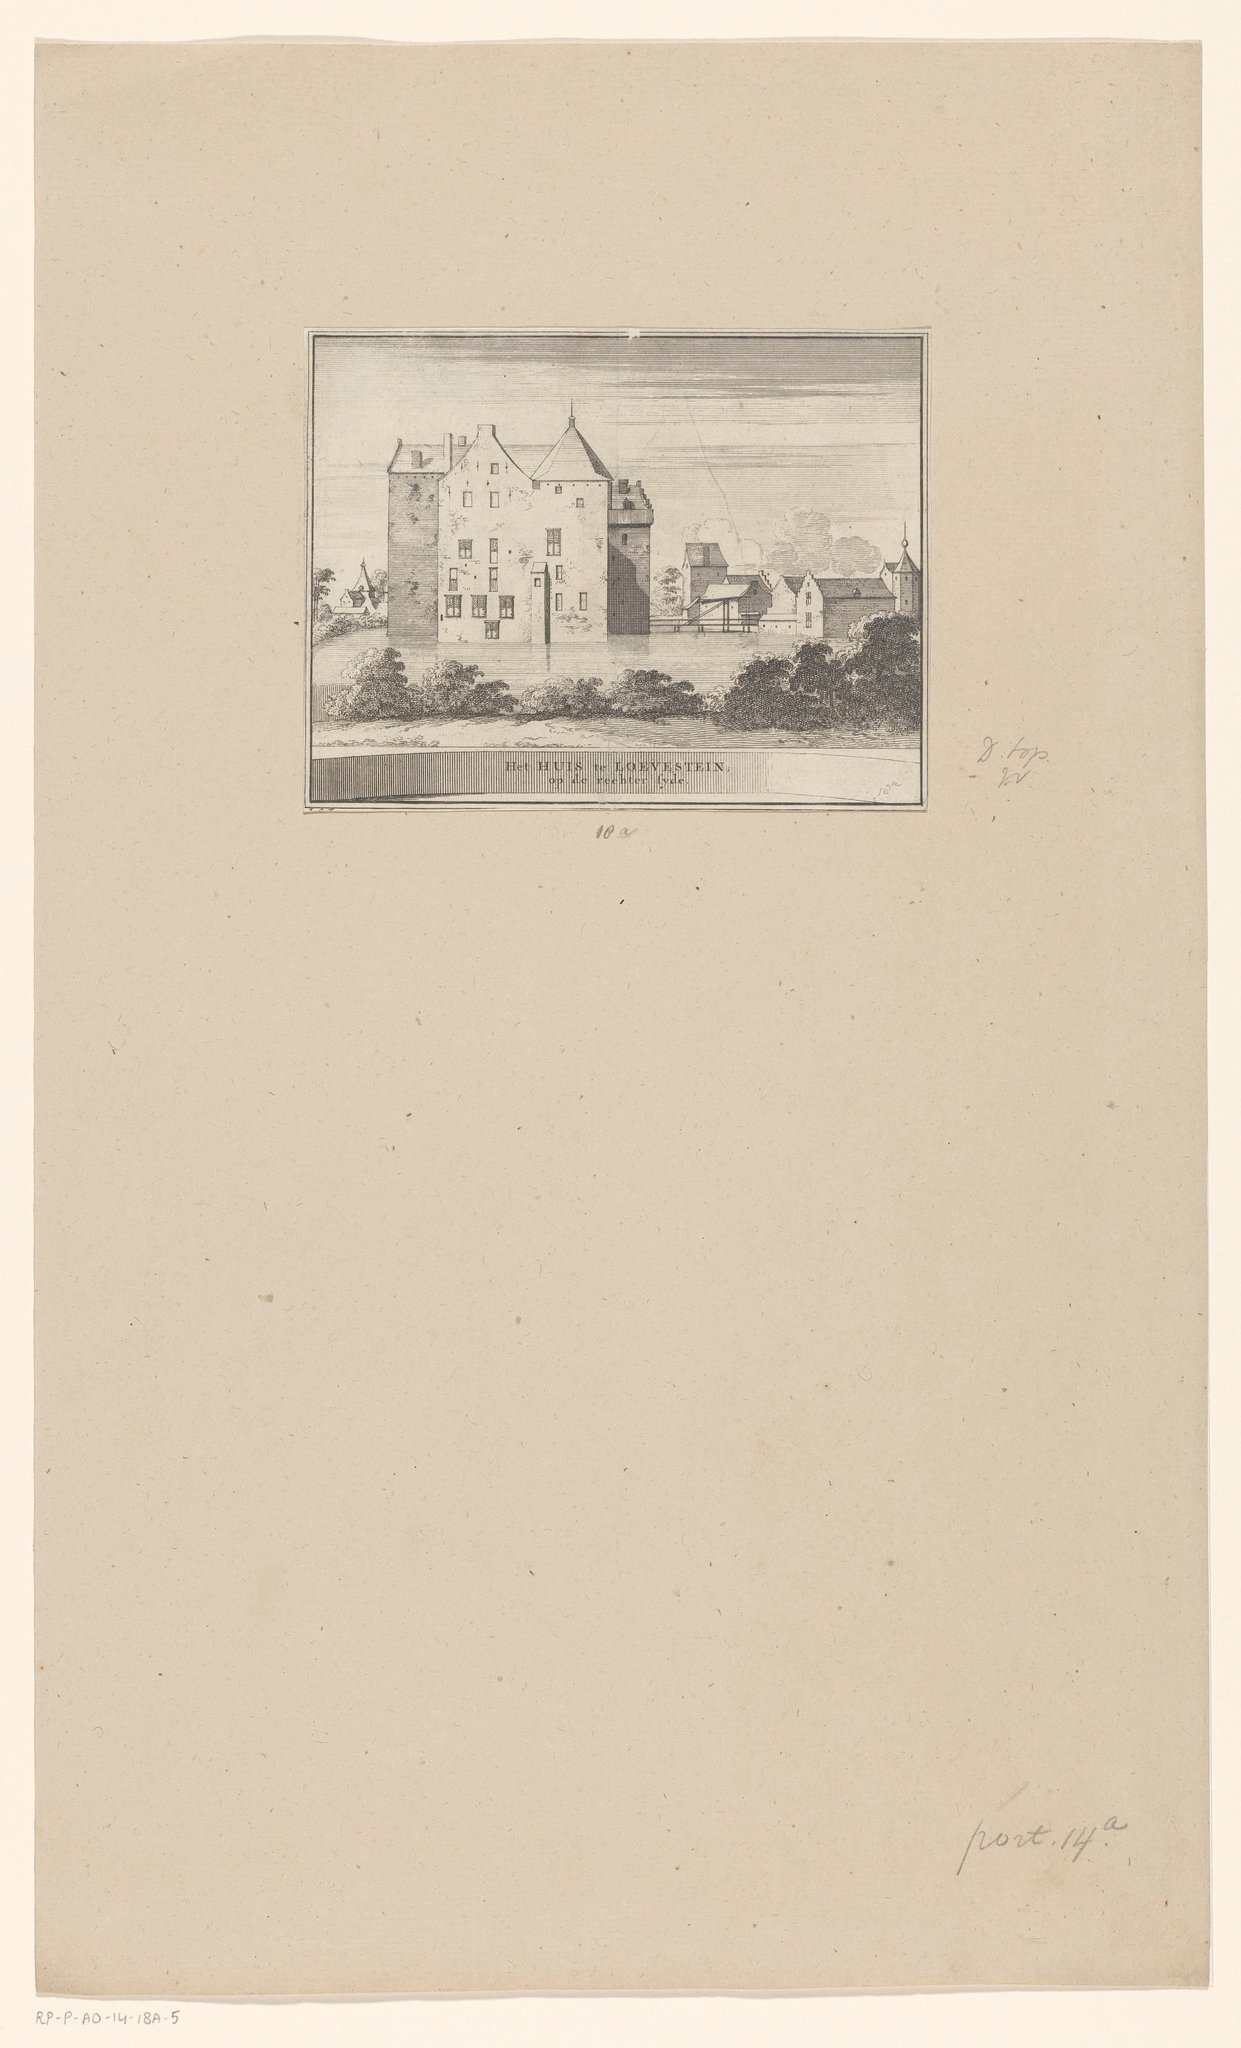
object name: book illustration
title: Het Huis te Loevestein op de rechter syde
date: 1711-1774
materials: paper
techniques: etching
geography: amsterdam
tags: castle, loevestein castle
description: Prent ook gebruikt in: Smids, Ludolf. Schatkamer der Nederlandsse oudheden; of woordenboek, behelsende Nederlands steden en dorpen, kasteelen, sloten en heeren huysen (…). Amsterdam: Pieter de Coup, 1711, tussen p. 208 en 209. Het is ook mogelijk dat deze prent uit de tweede (1737) of derde (1774) druk komt, of uit een uitgave met alleen de prenten: Nederlandsche oudheden, bestaande in zestig verbeeldingen (...) gelegen in Holland, 't Sticht van Utrecht en Gelderland enz. Amsterdam: Hendrik Bosch, 1721.